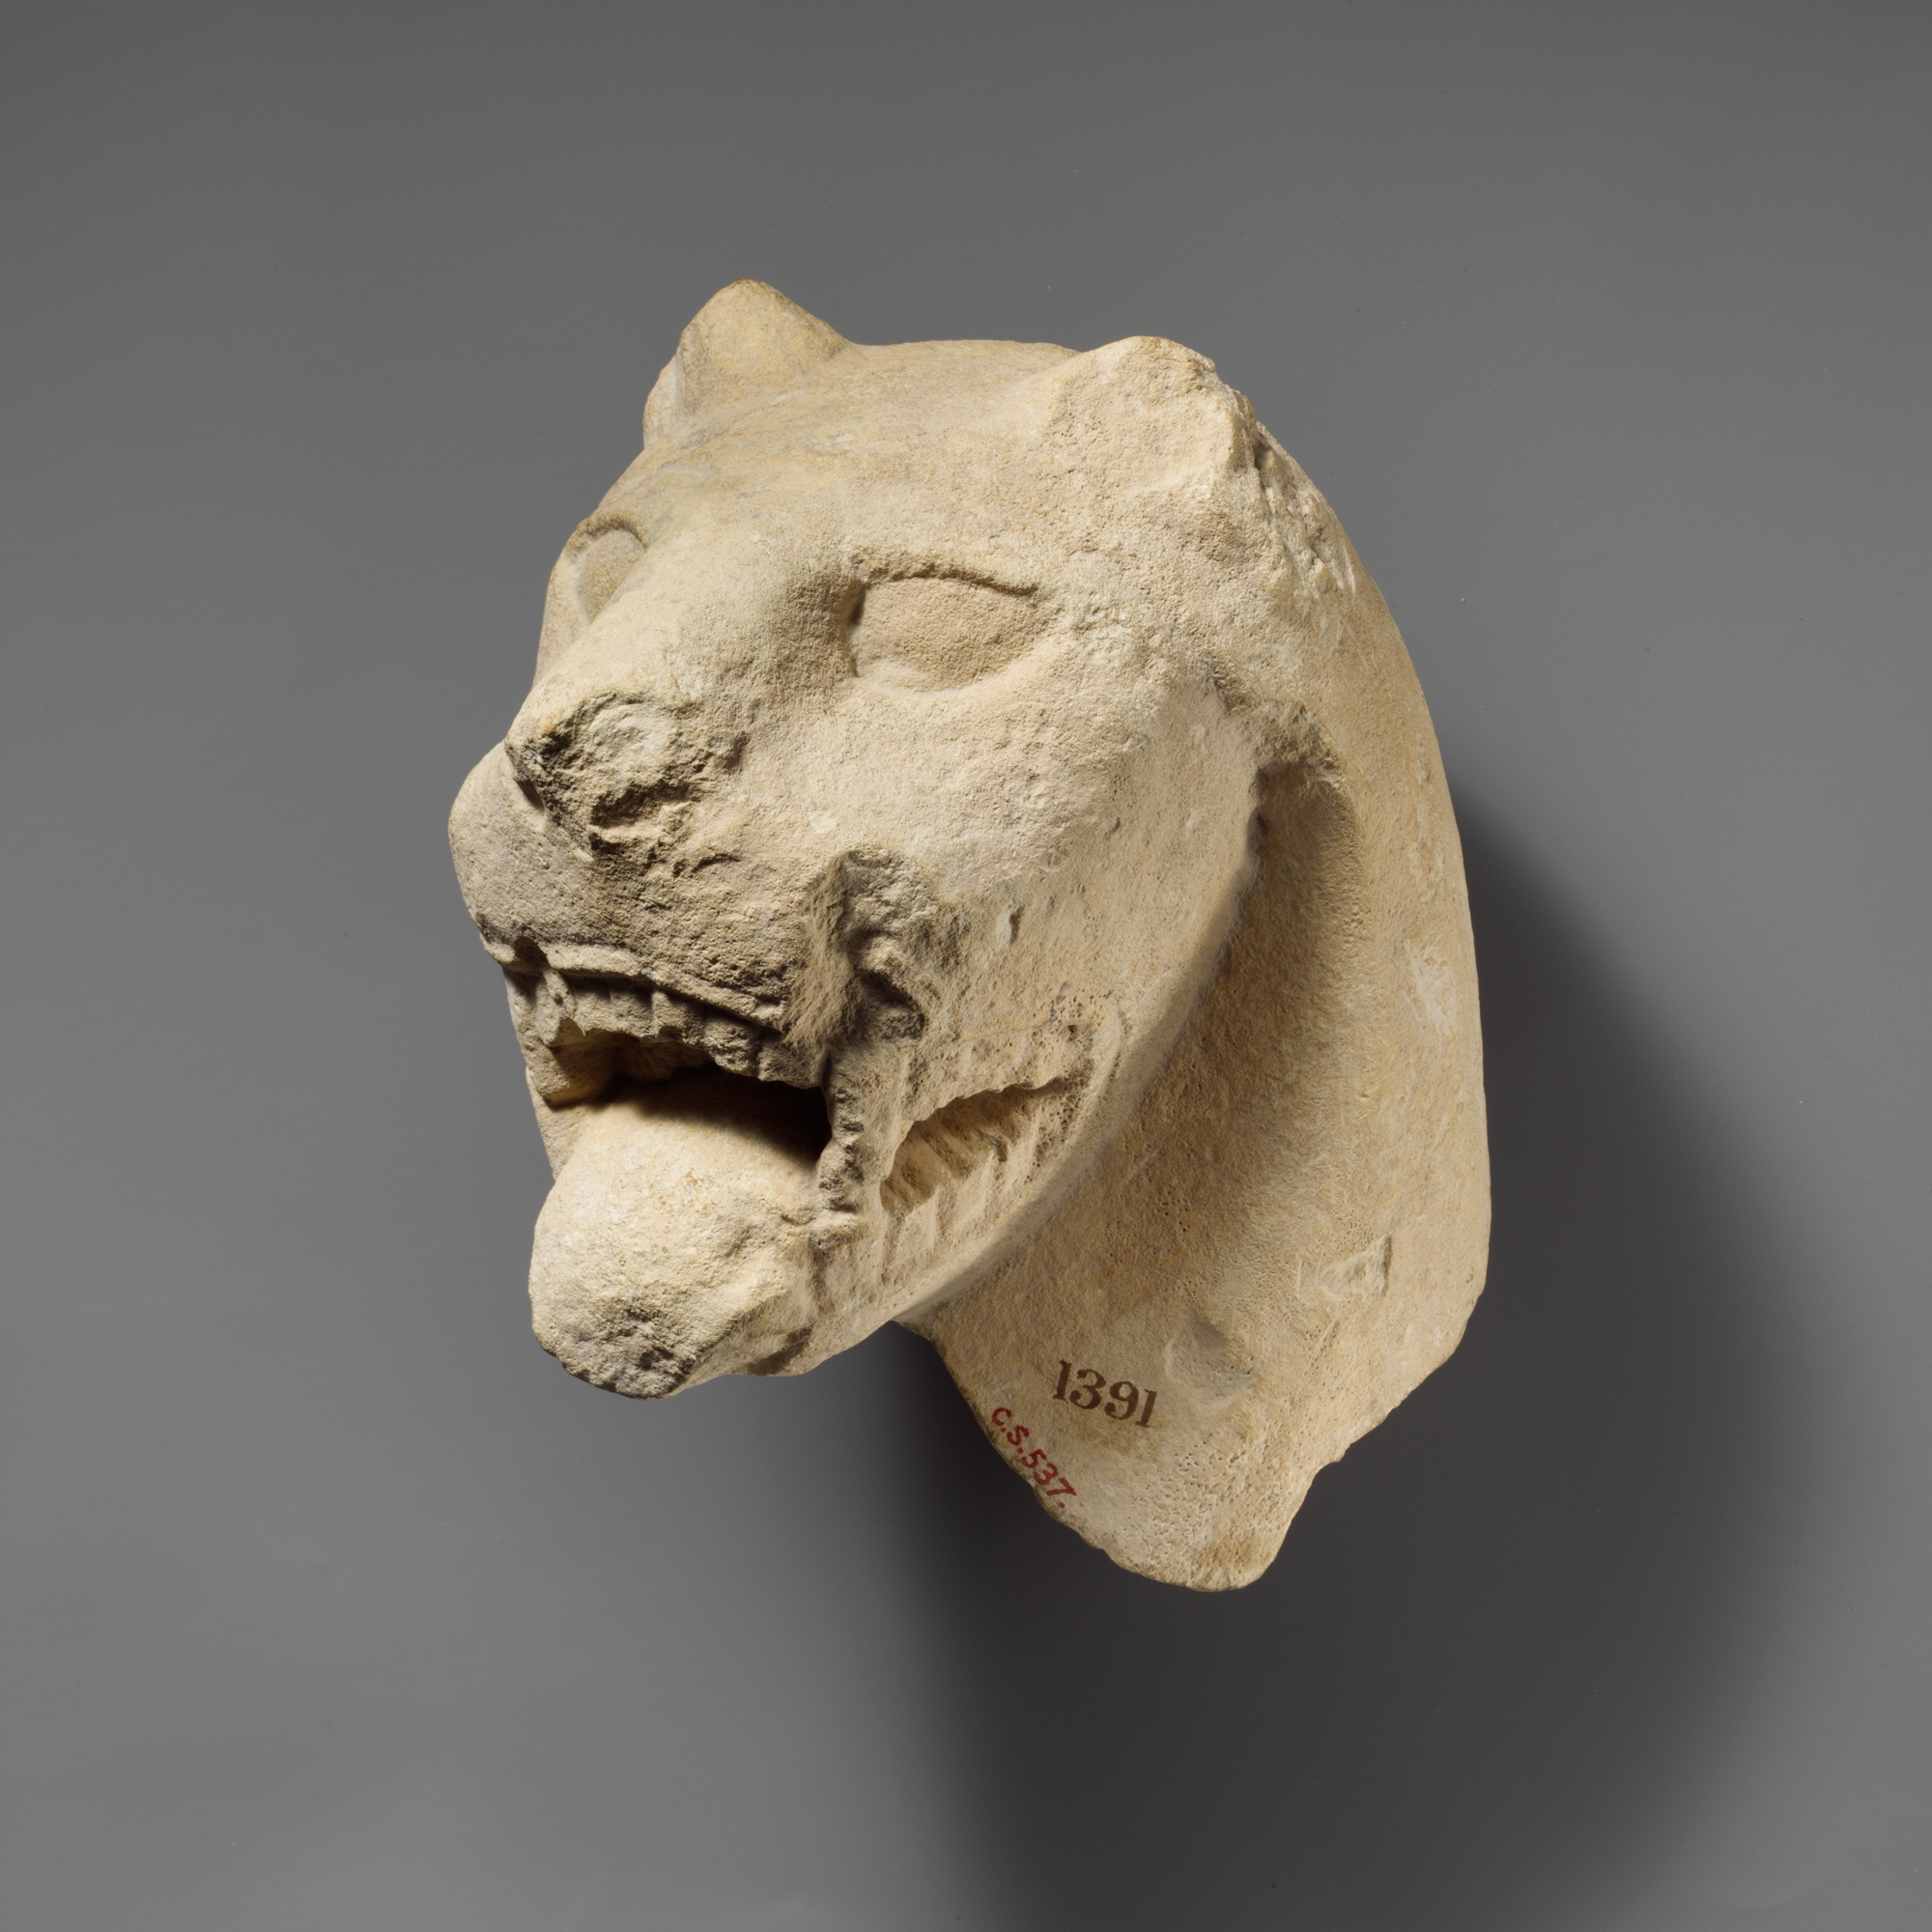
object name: head of a lion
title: Limestone head of a lion from a votive stele (?)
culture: cypriot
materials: limestone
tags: lions